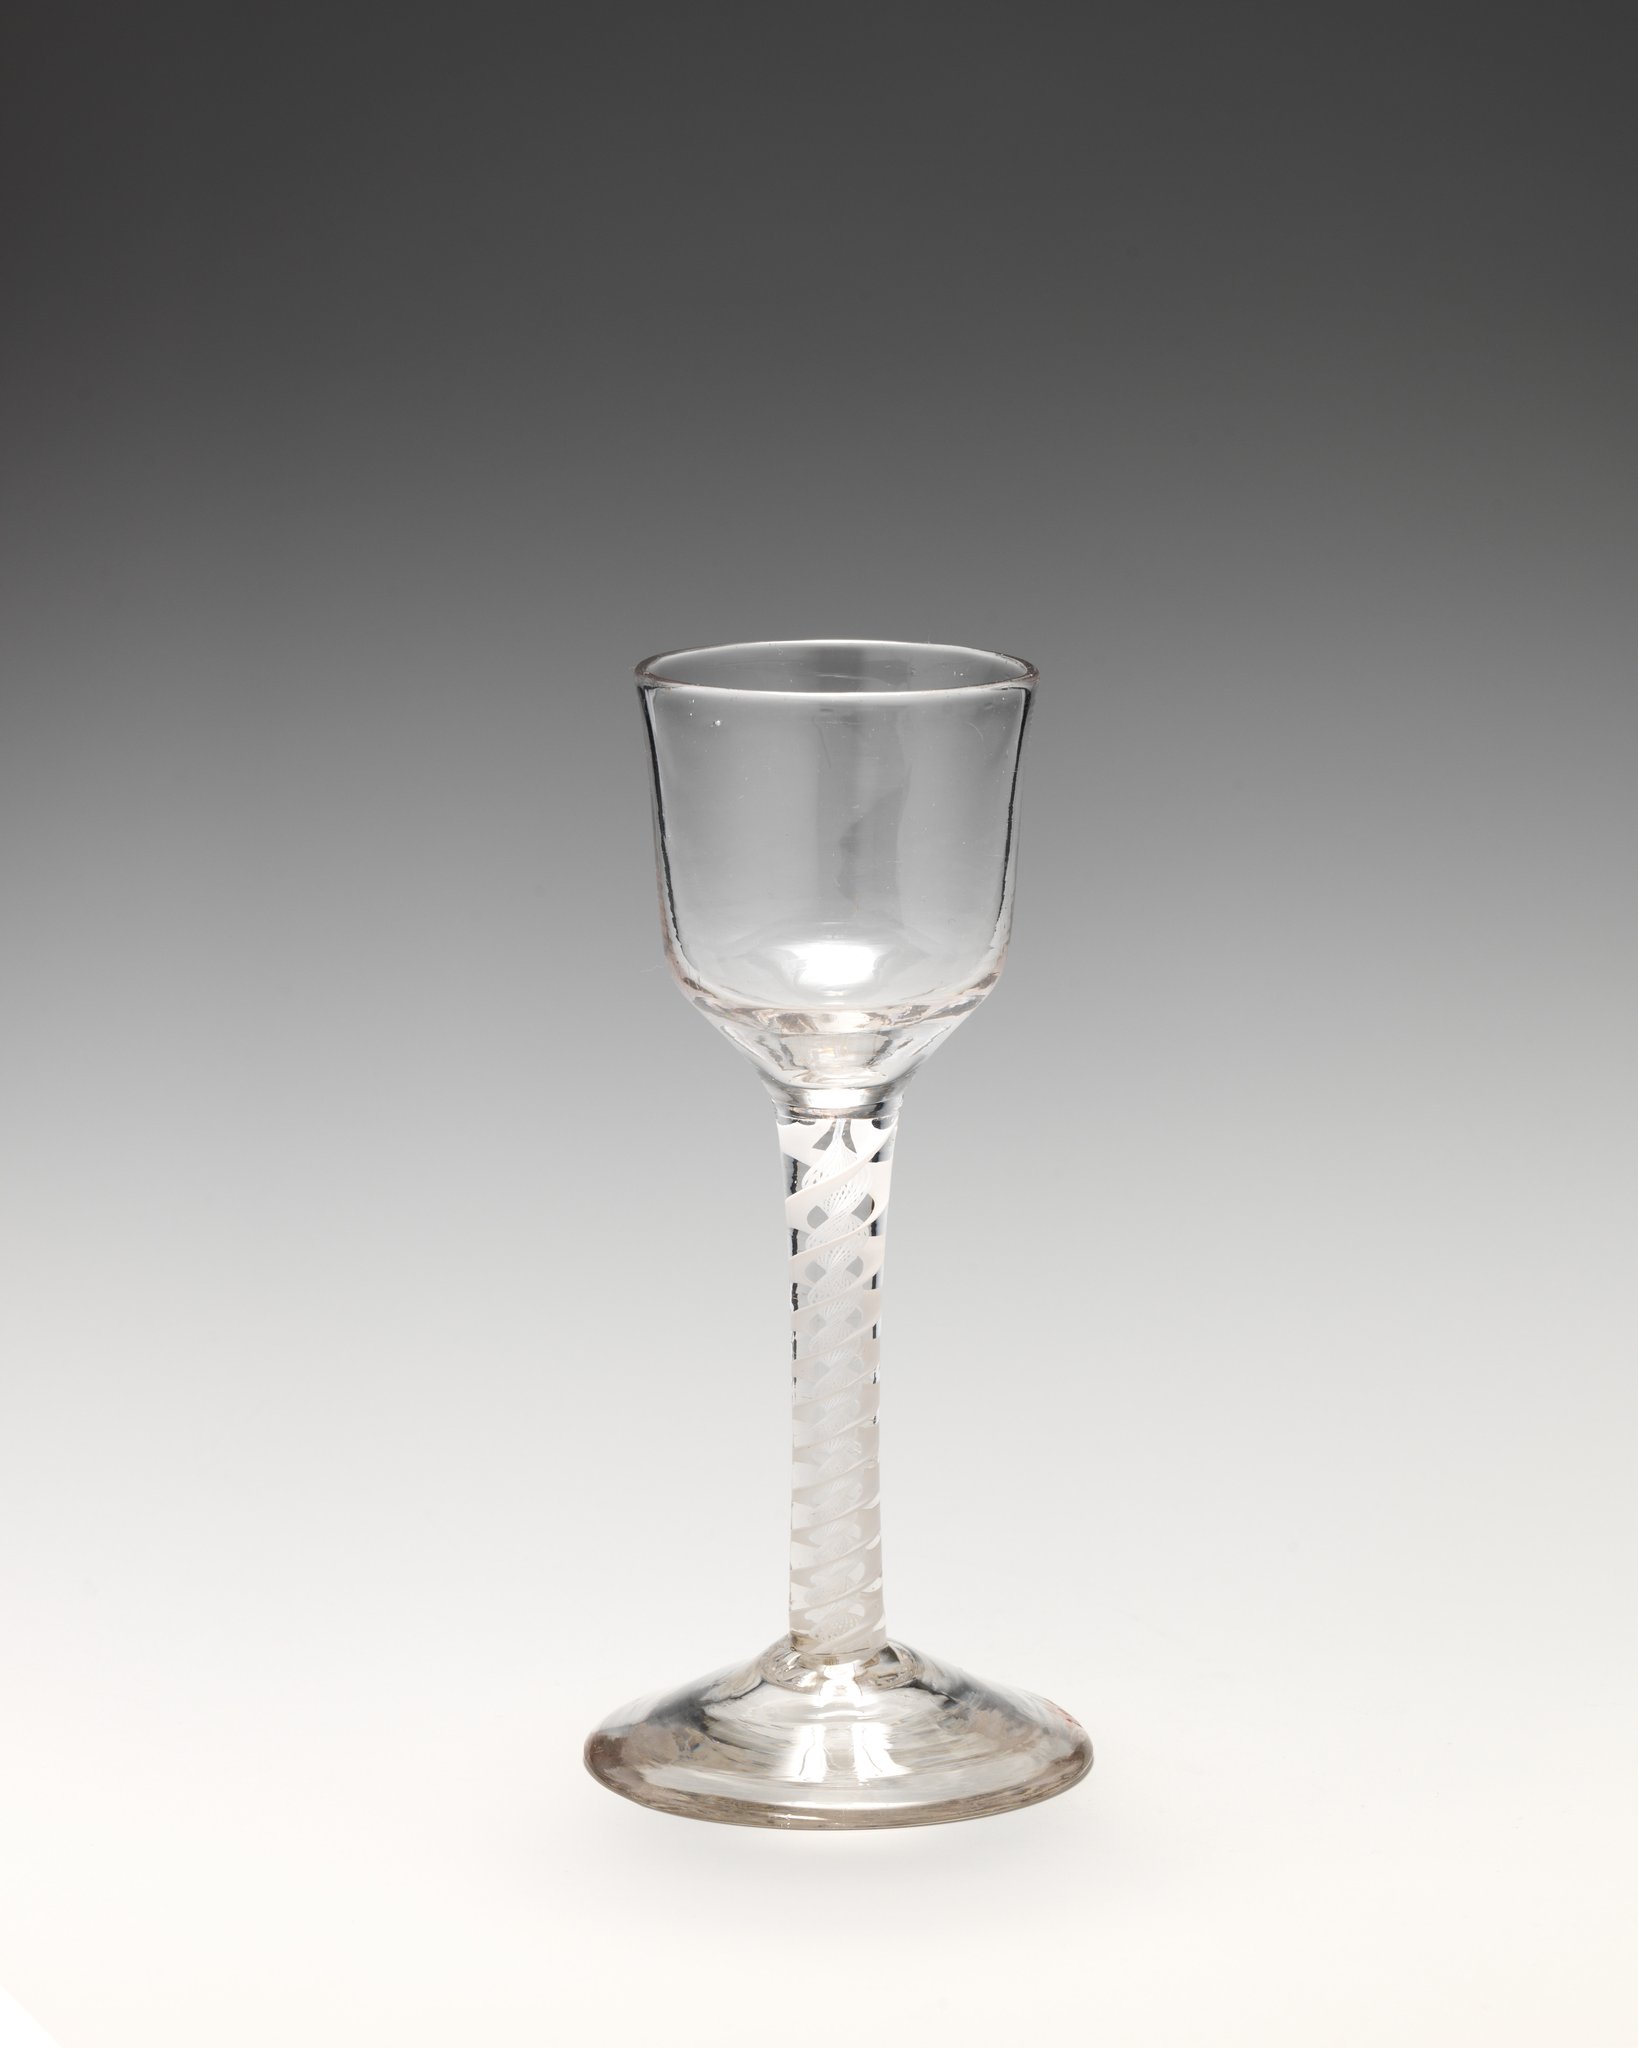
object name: wineglass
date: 1750-1800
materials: glass